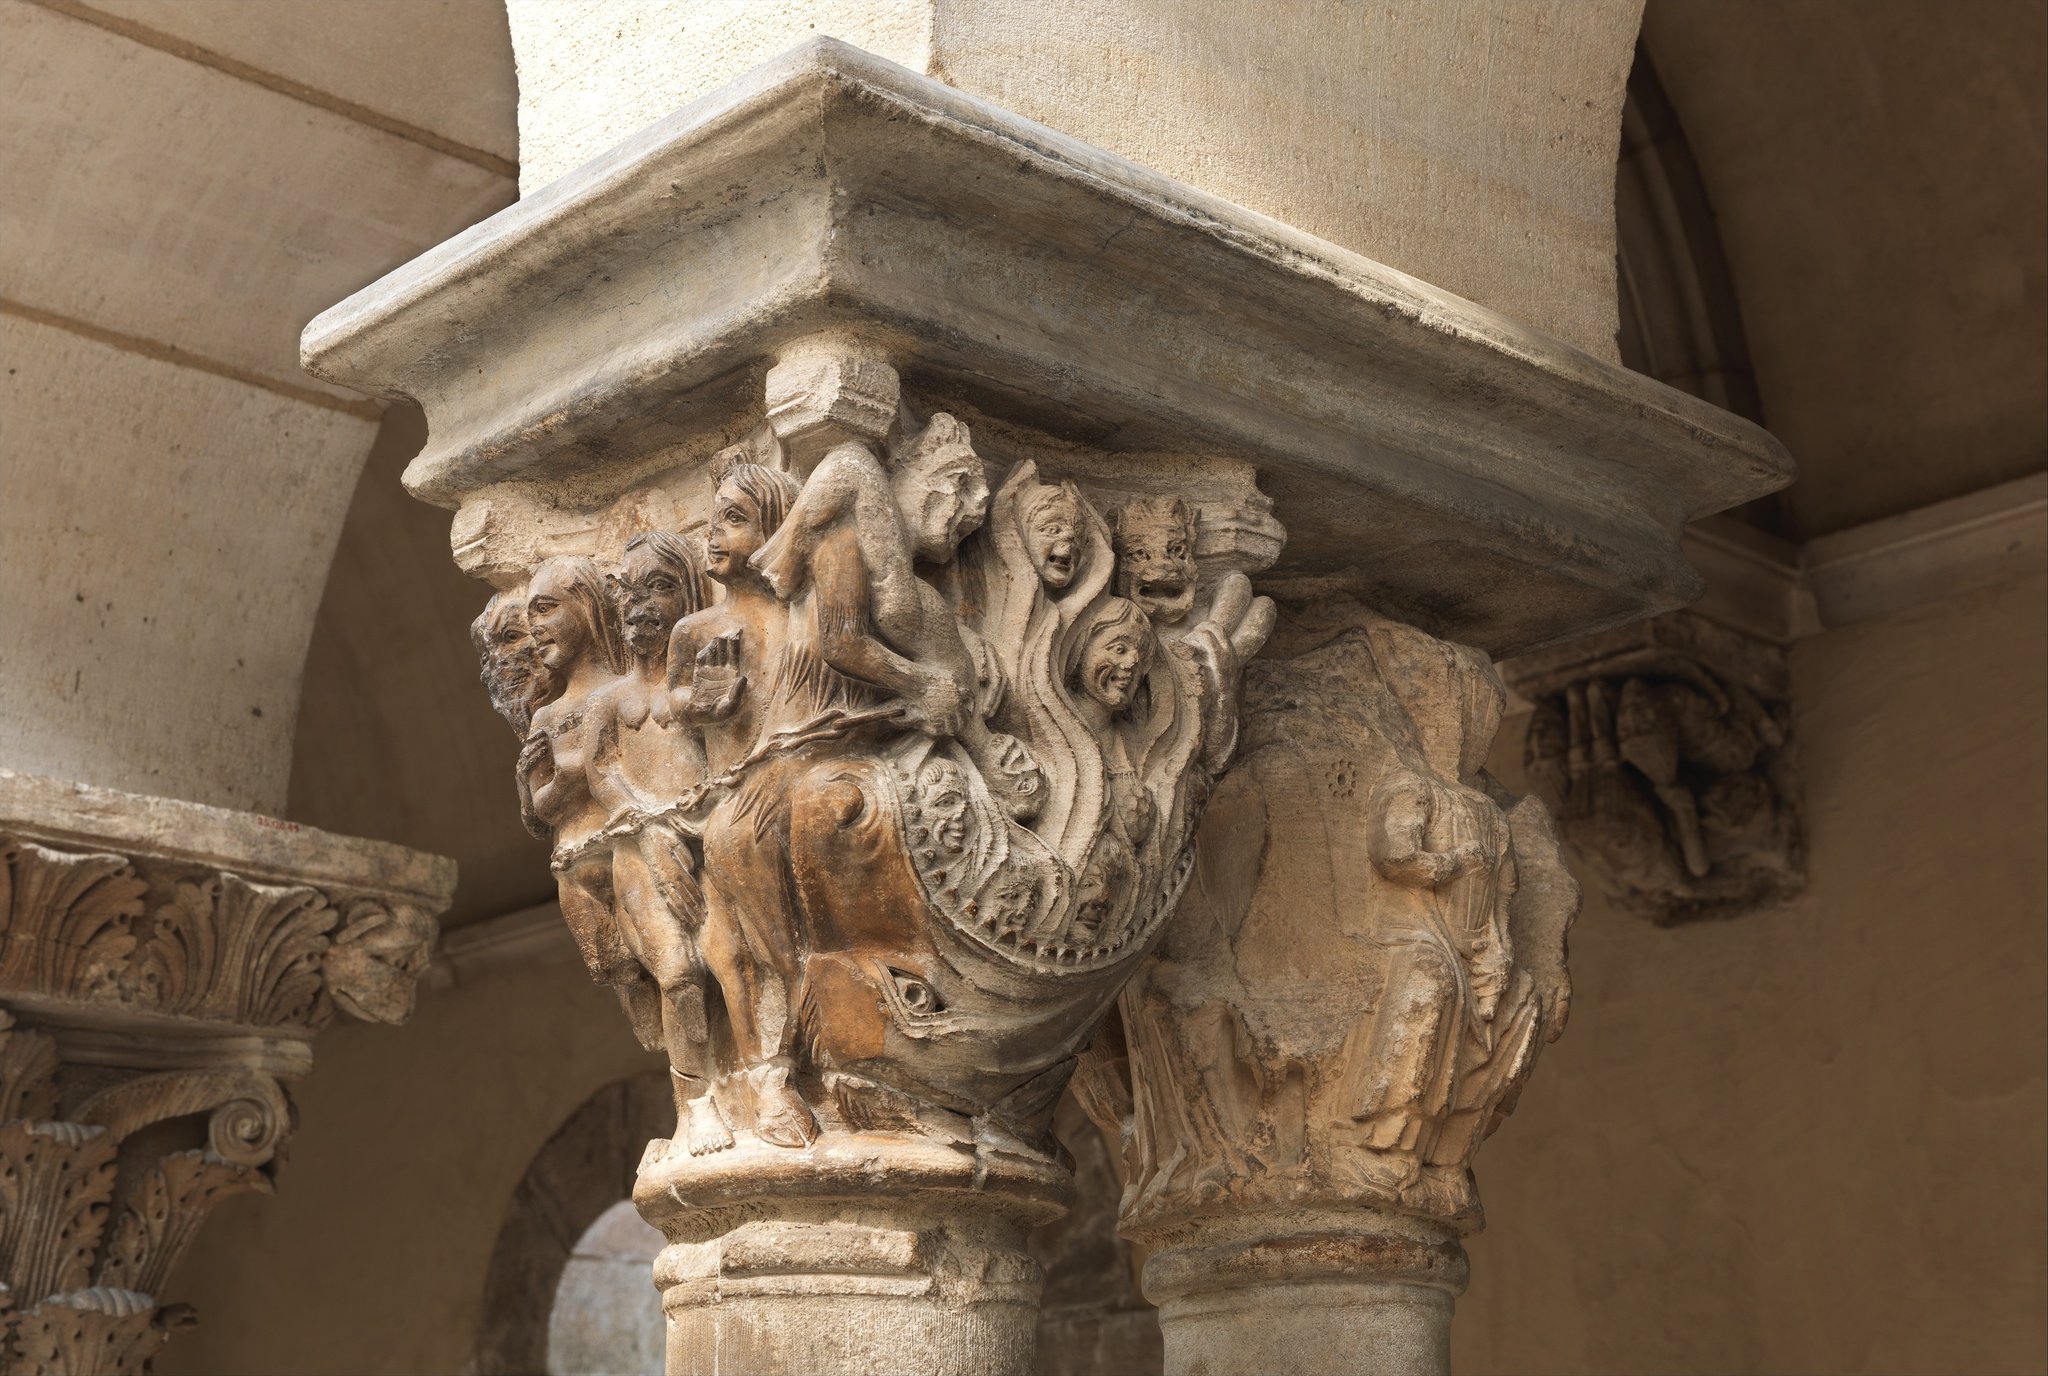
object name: capital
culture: french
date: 1167-1200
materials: stone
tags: last judgement